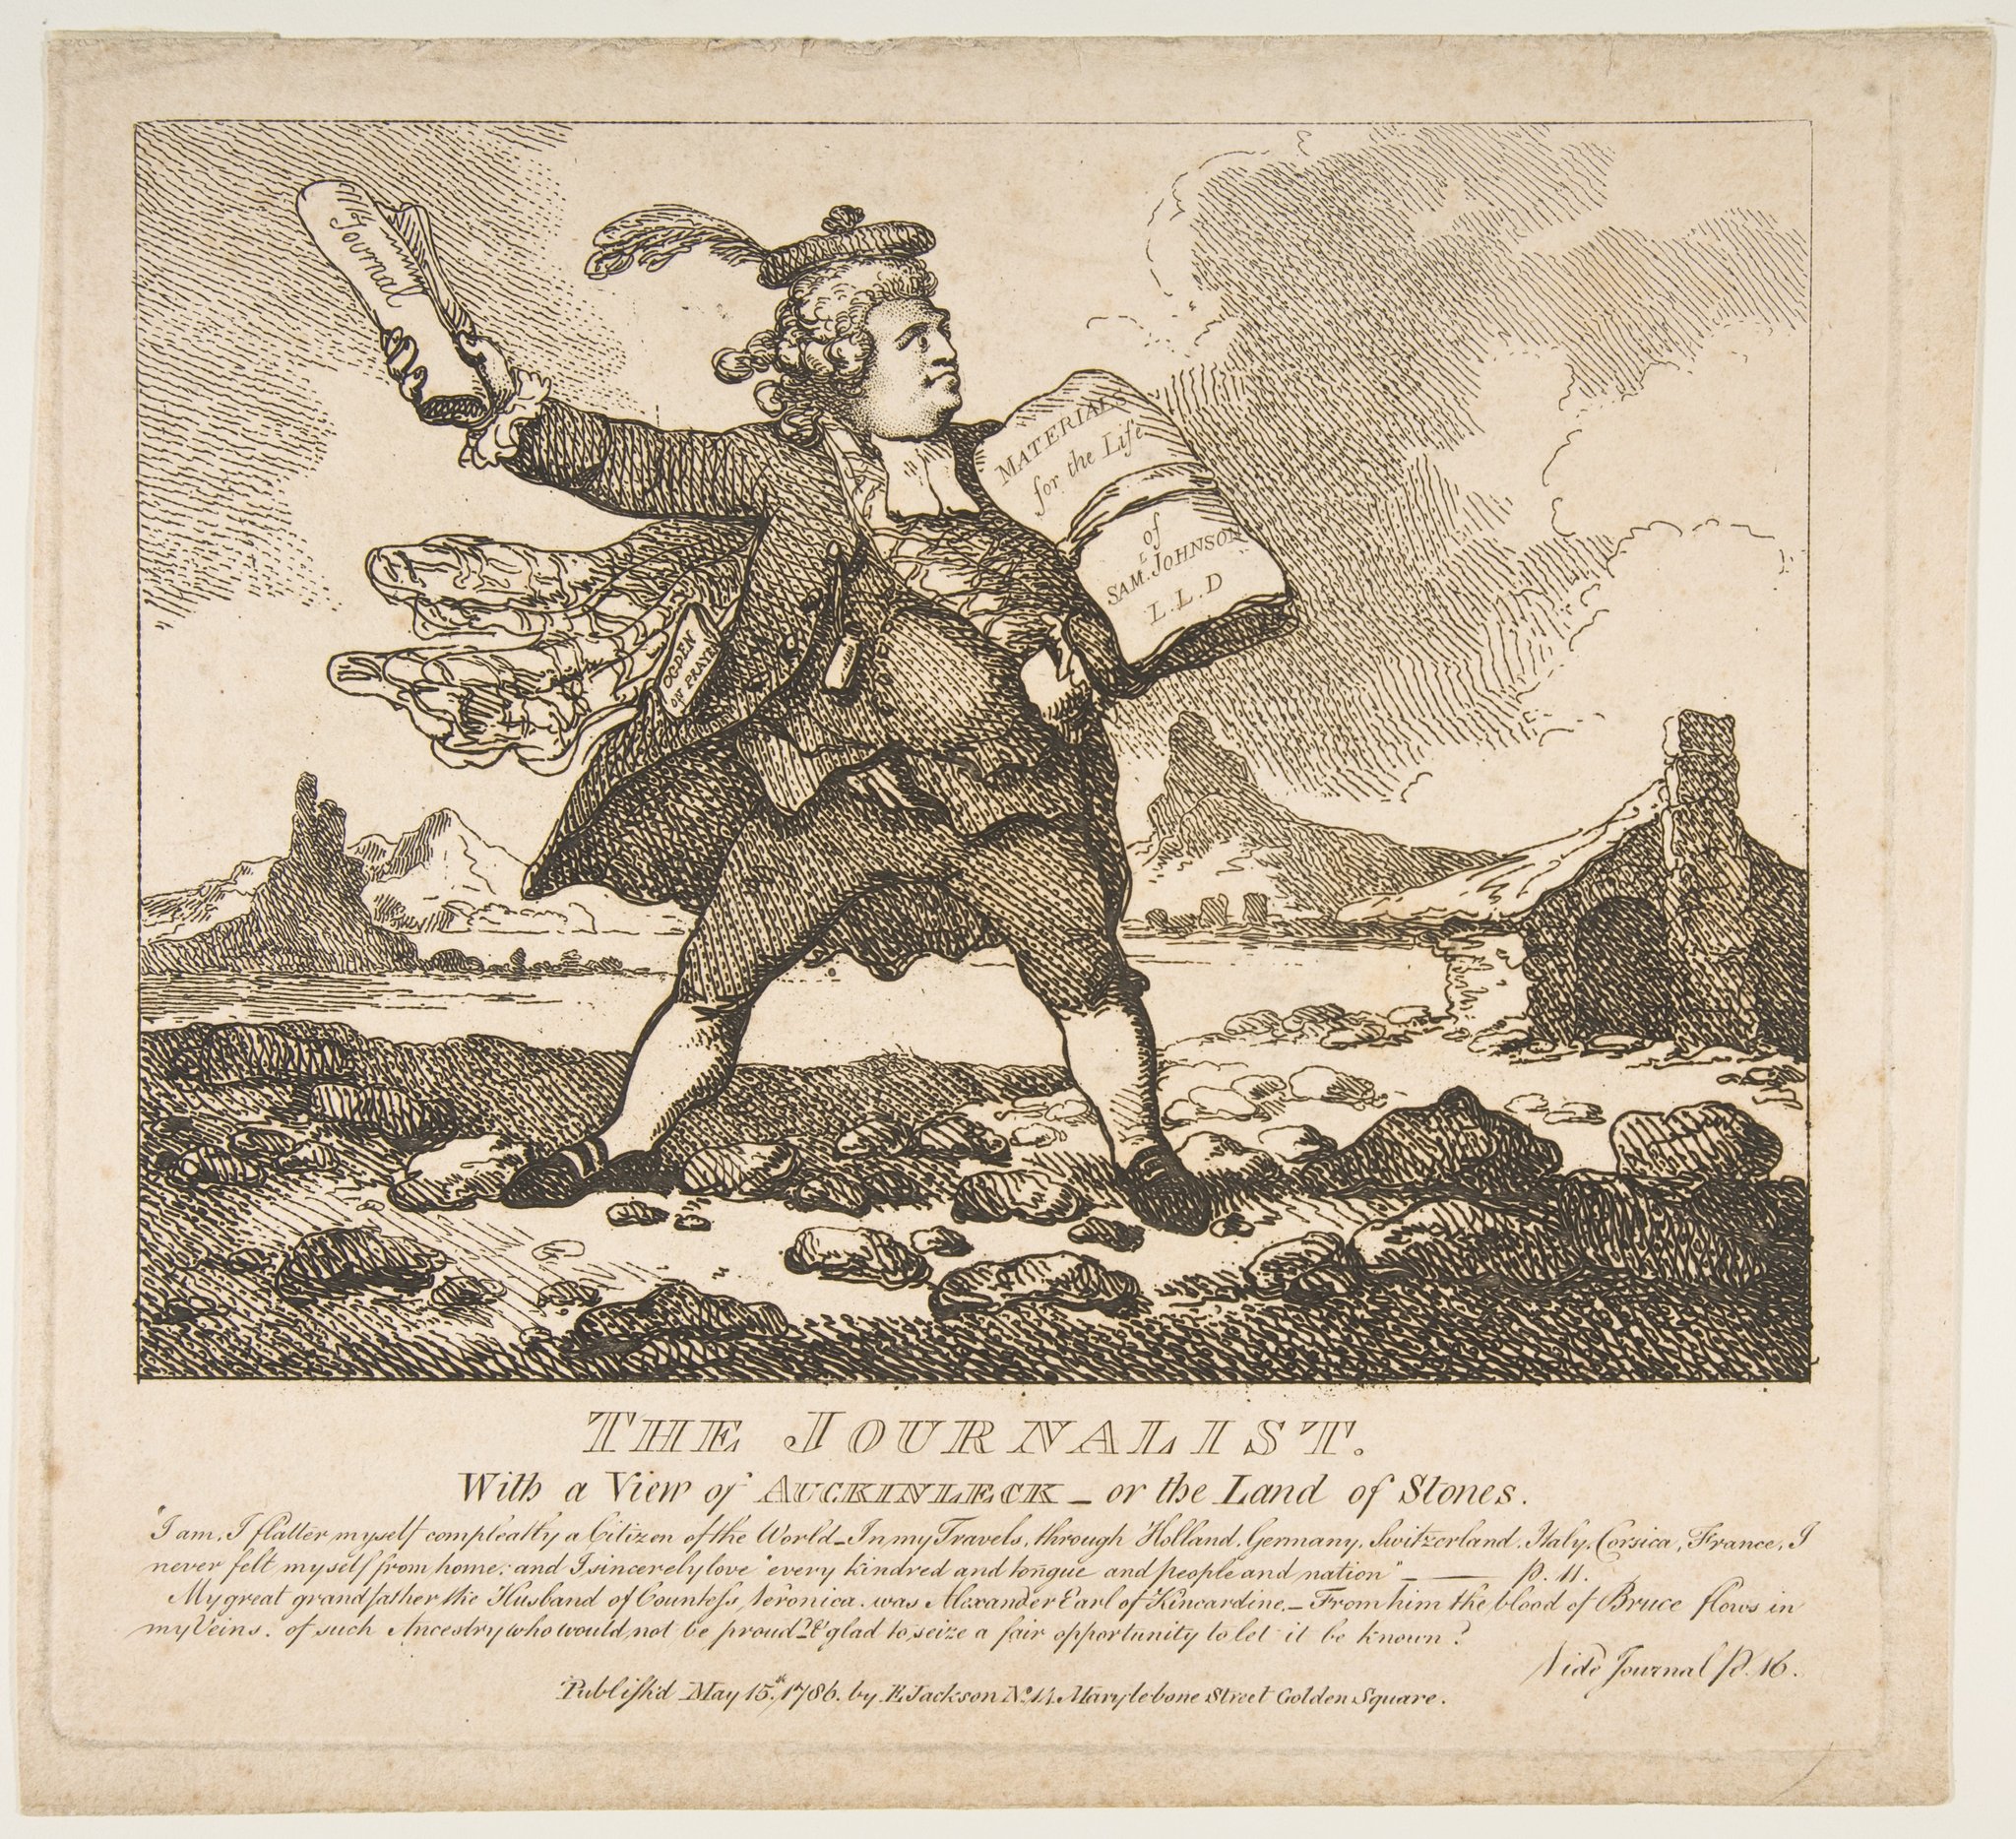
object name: print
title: The Journalist, With a View of Auckinleck–or the Land of Stones (Picturesque Beauties of Boswell, Part the First)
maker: thomas rowlandson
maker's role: artist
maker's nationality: british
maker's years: 1757-1827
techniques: etching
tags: satire,men